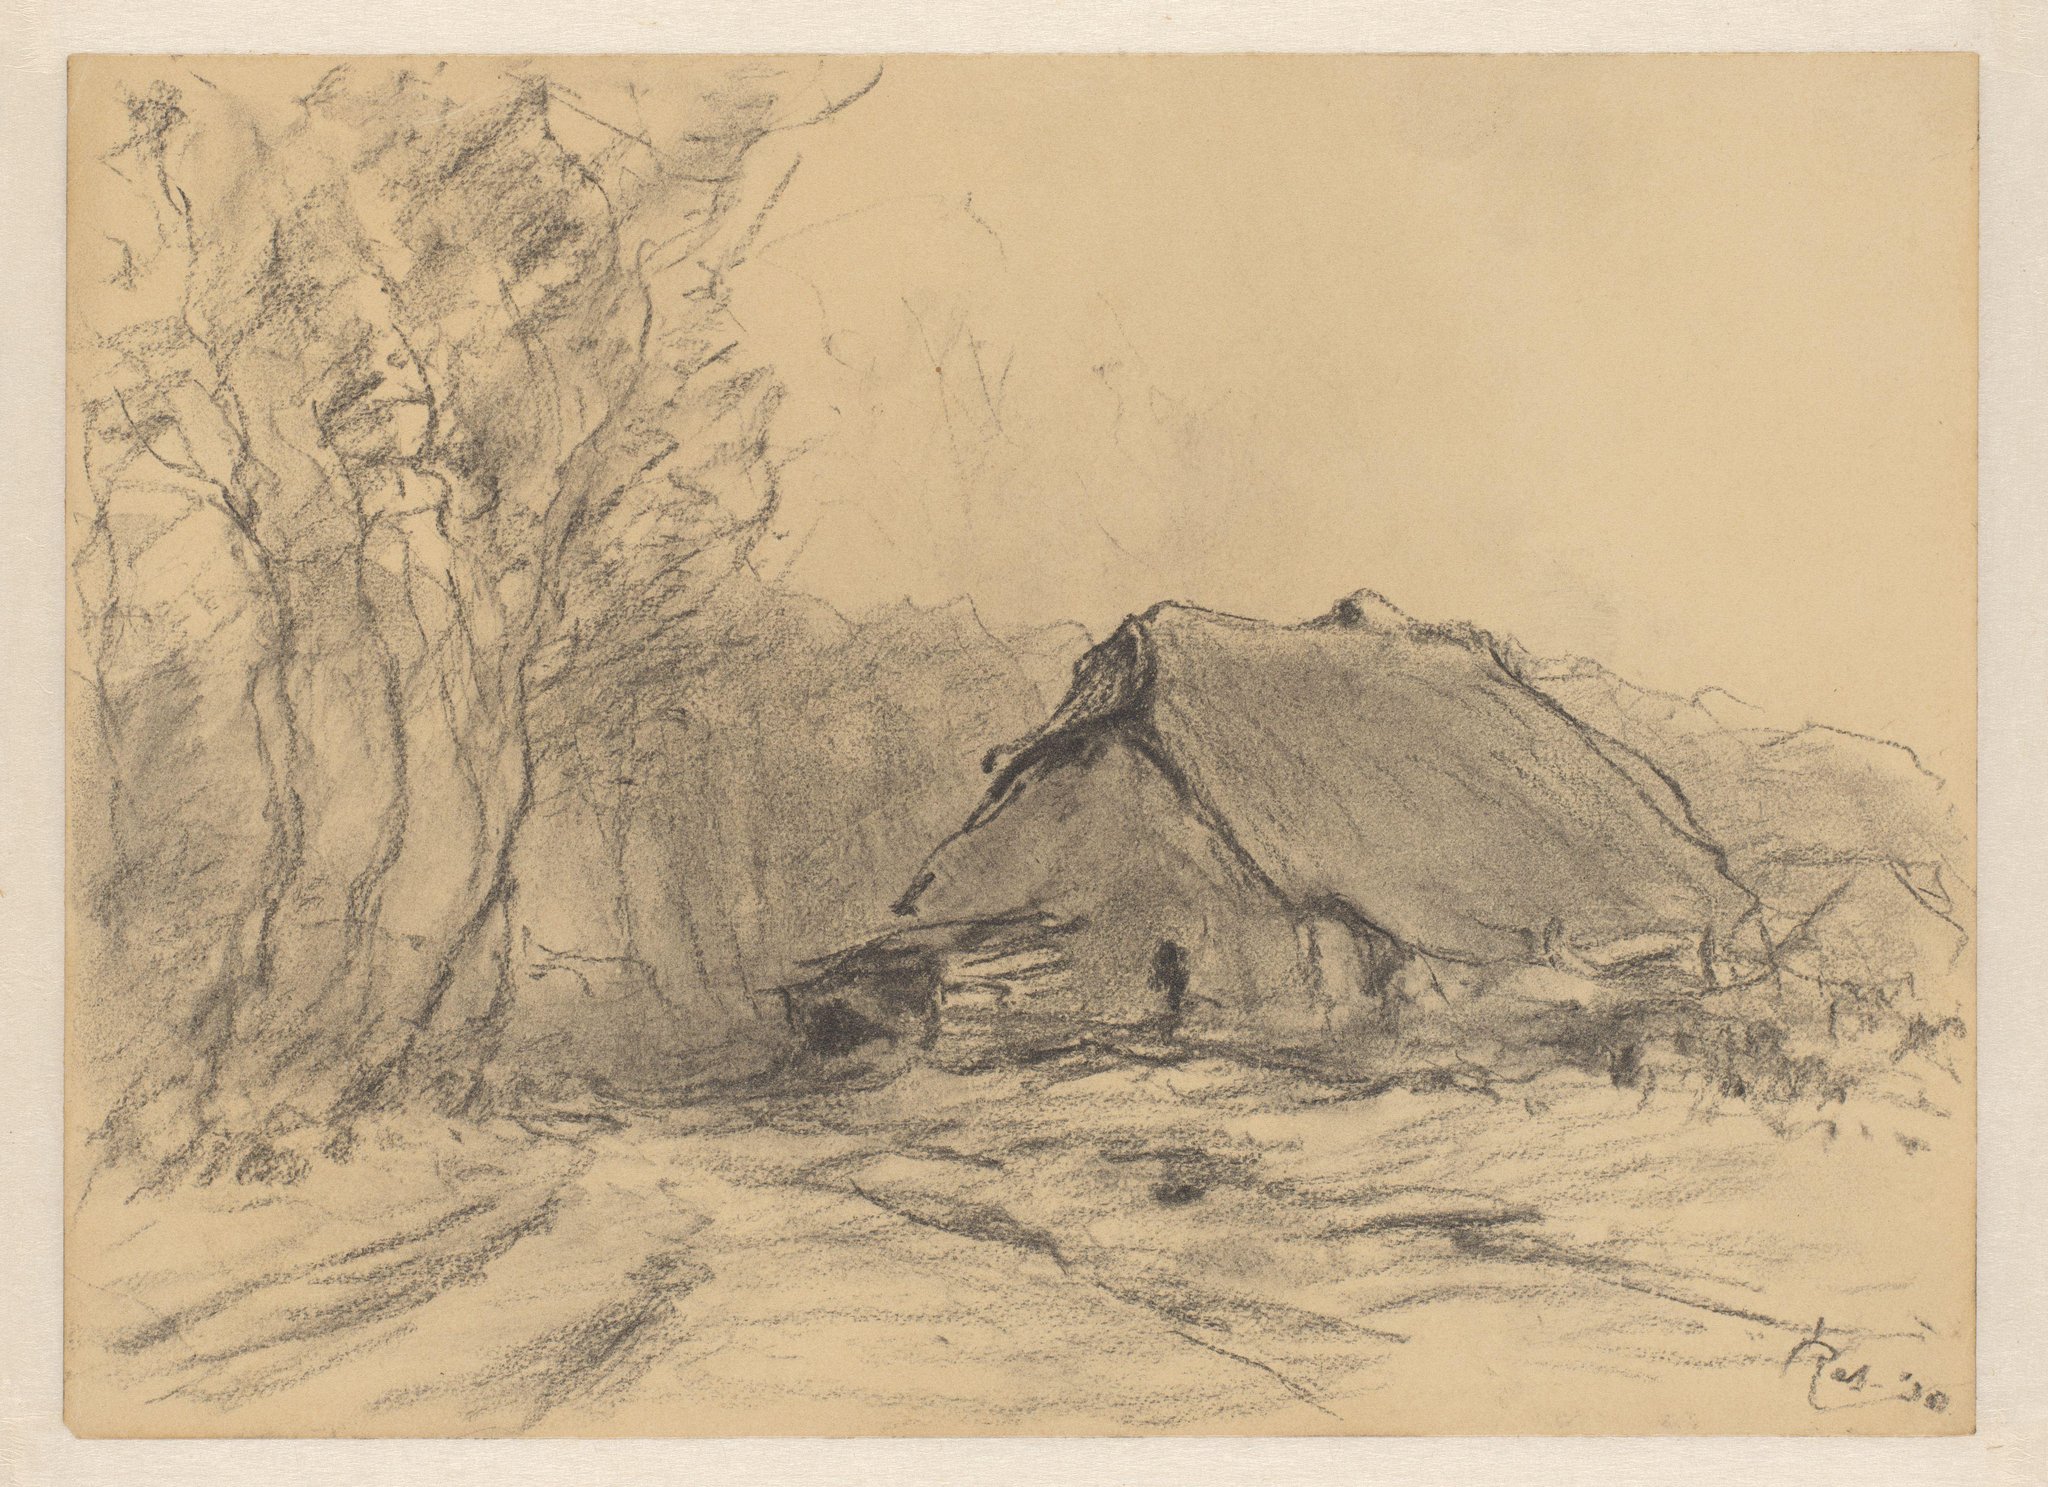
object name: drawing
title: Woning bij bosrand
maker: pieter h.j.j. ras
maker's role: draughtsman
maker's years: 1857-1941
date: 1930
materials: chalk, paper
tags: farm (building)